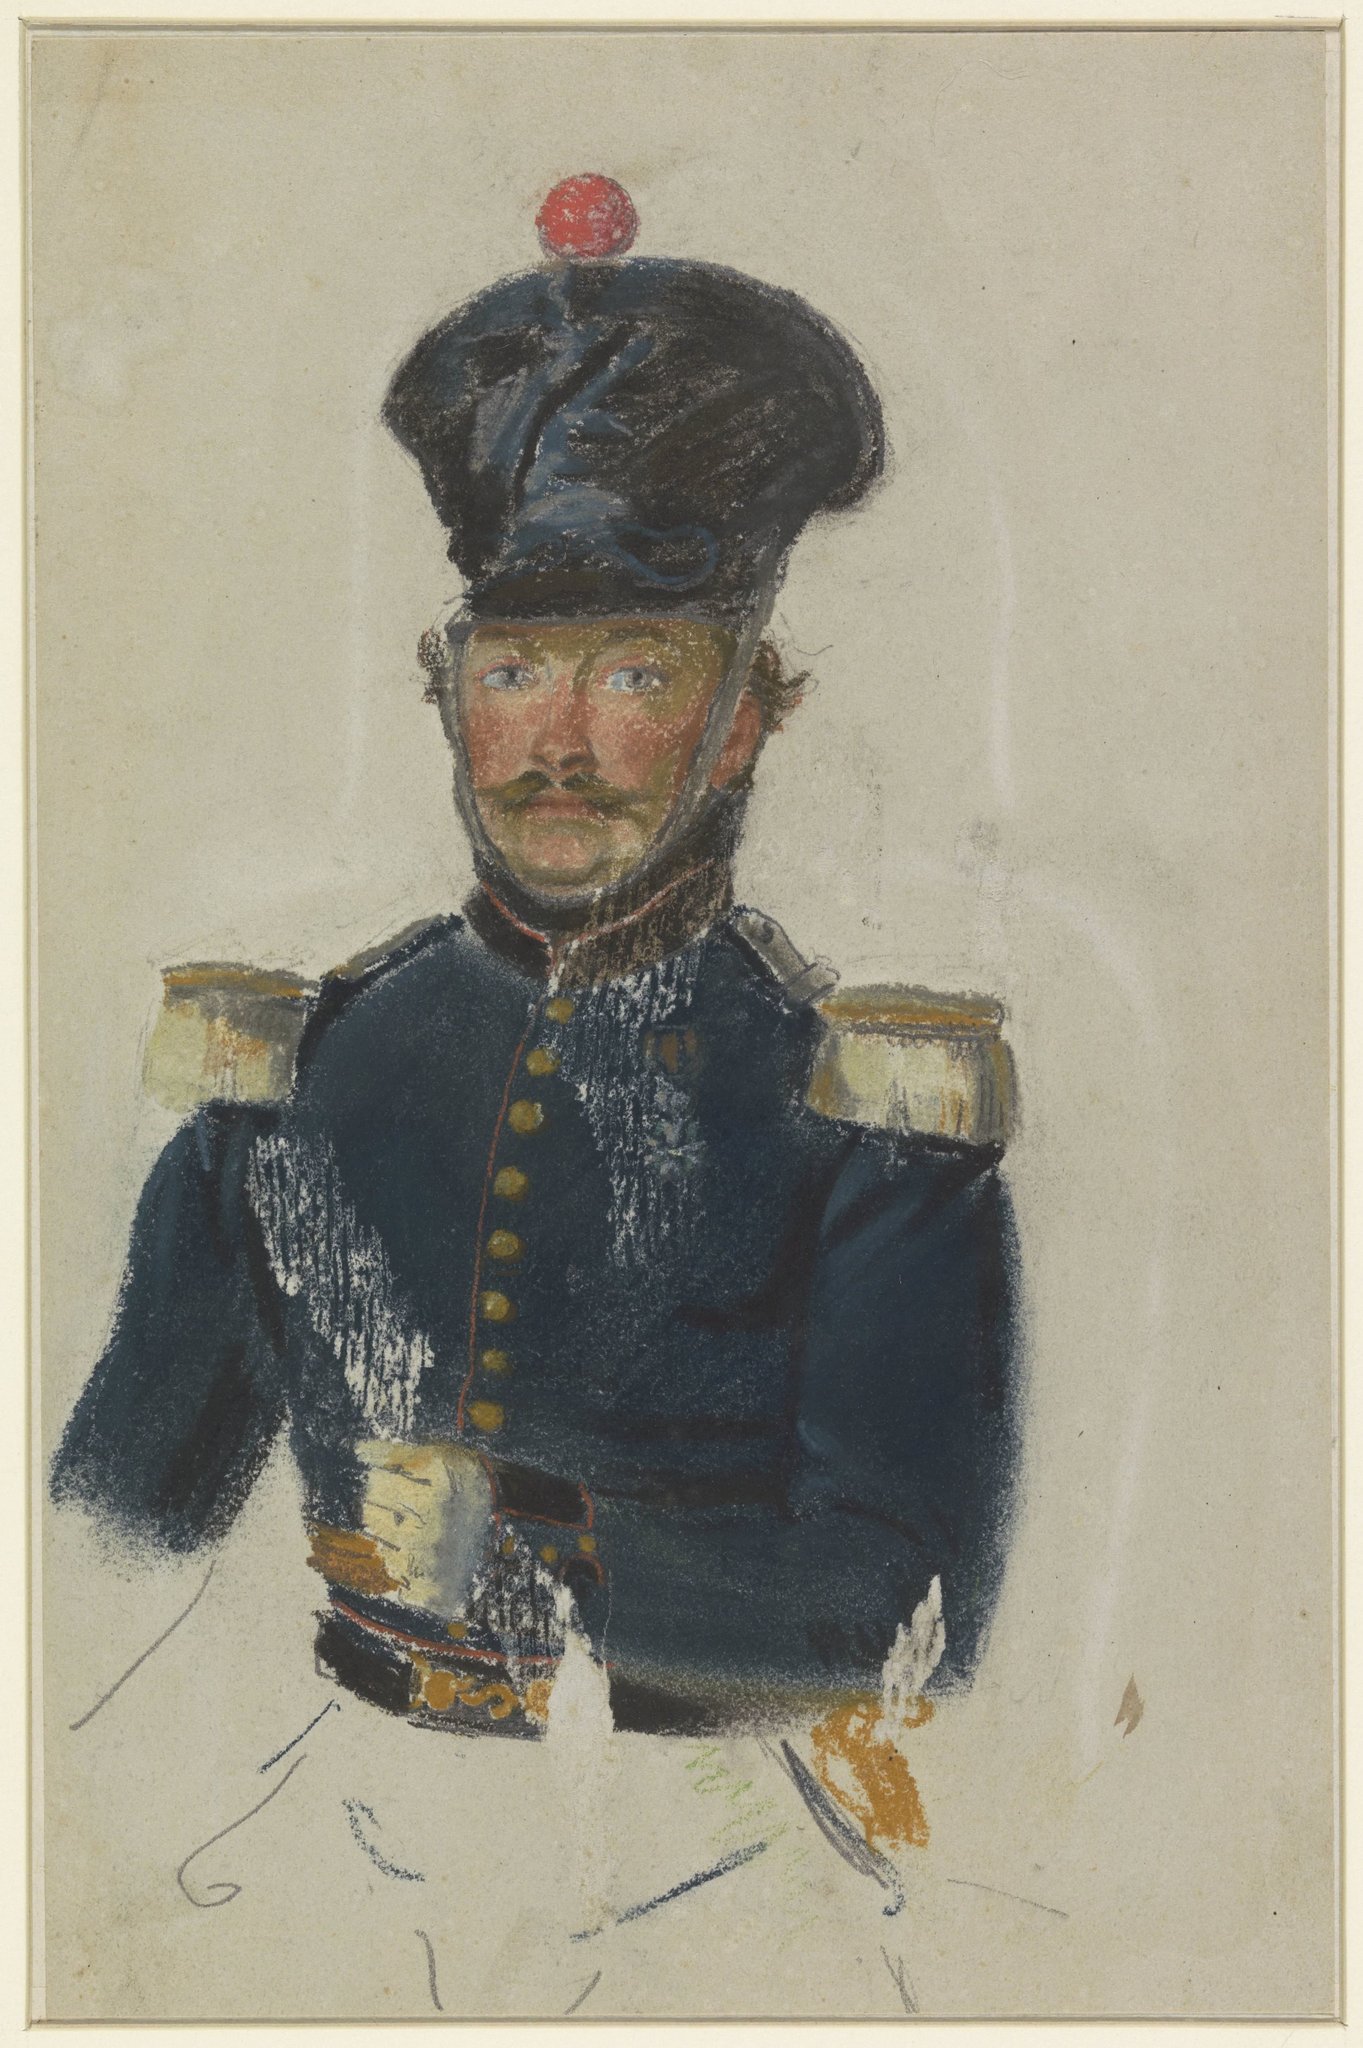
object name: drawing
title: Portret van een officier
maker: jacob joseph eeckhout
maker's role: draughtsman, print maker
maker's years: 1793-1861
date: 1803-1861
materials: paint, paper, pastel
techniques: brush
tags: anonymous historical person portrayed alone, officer